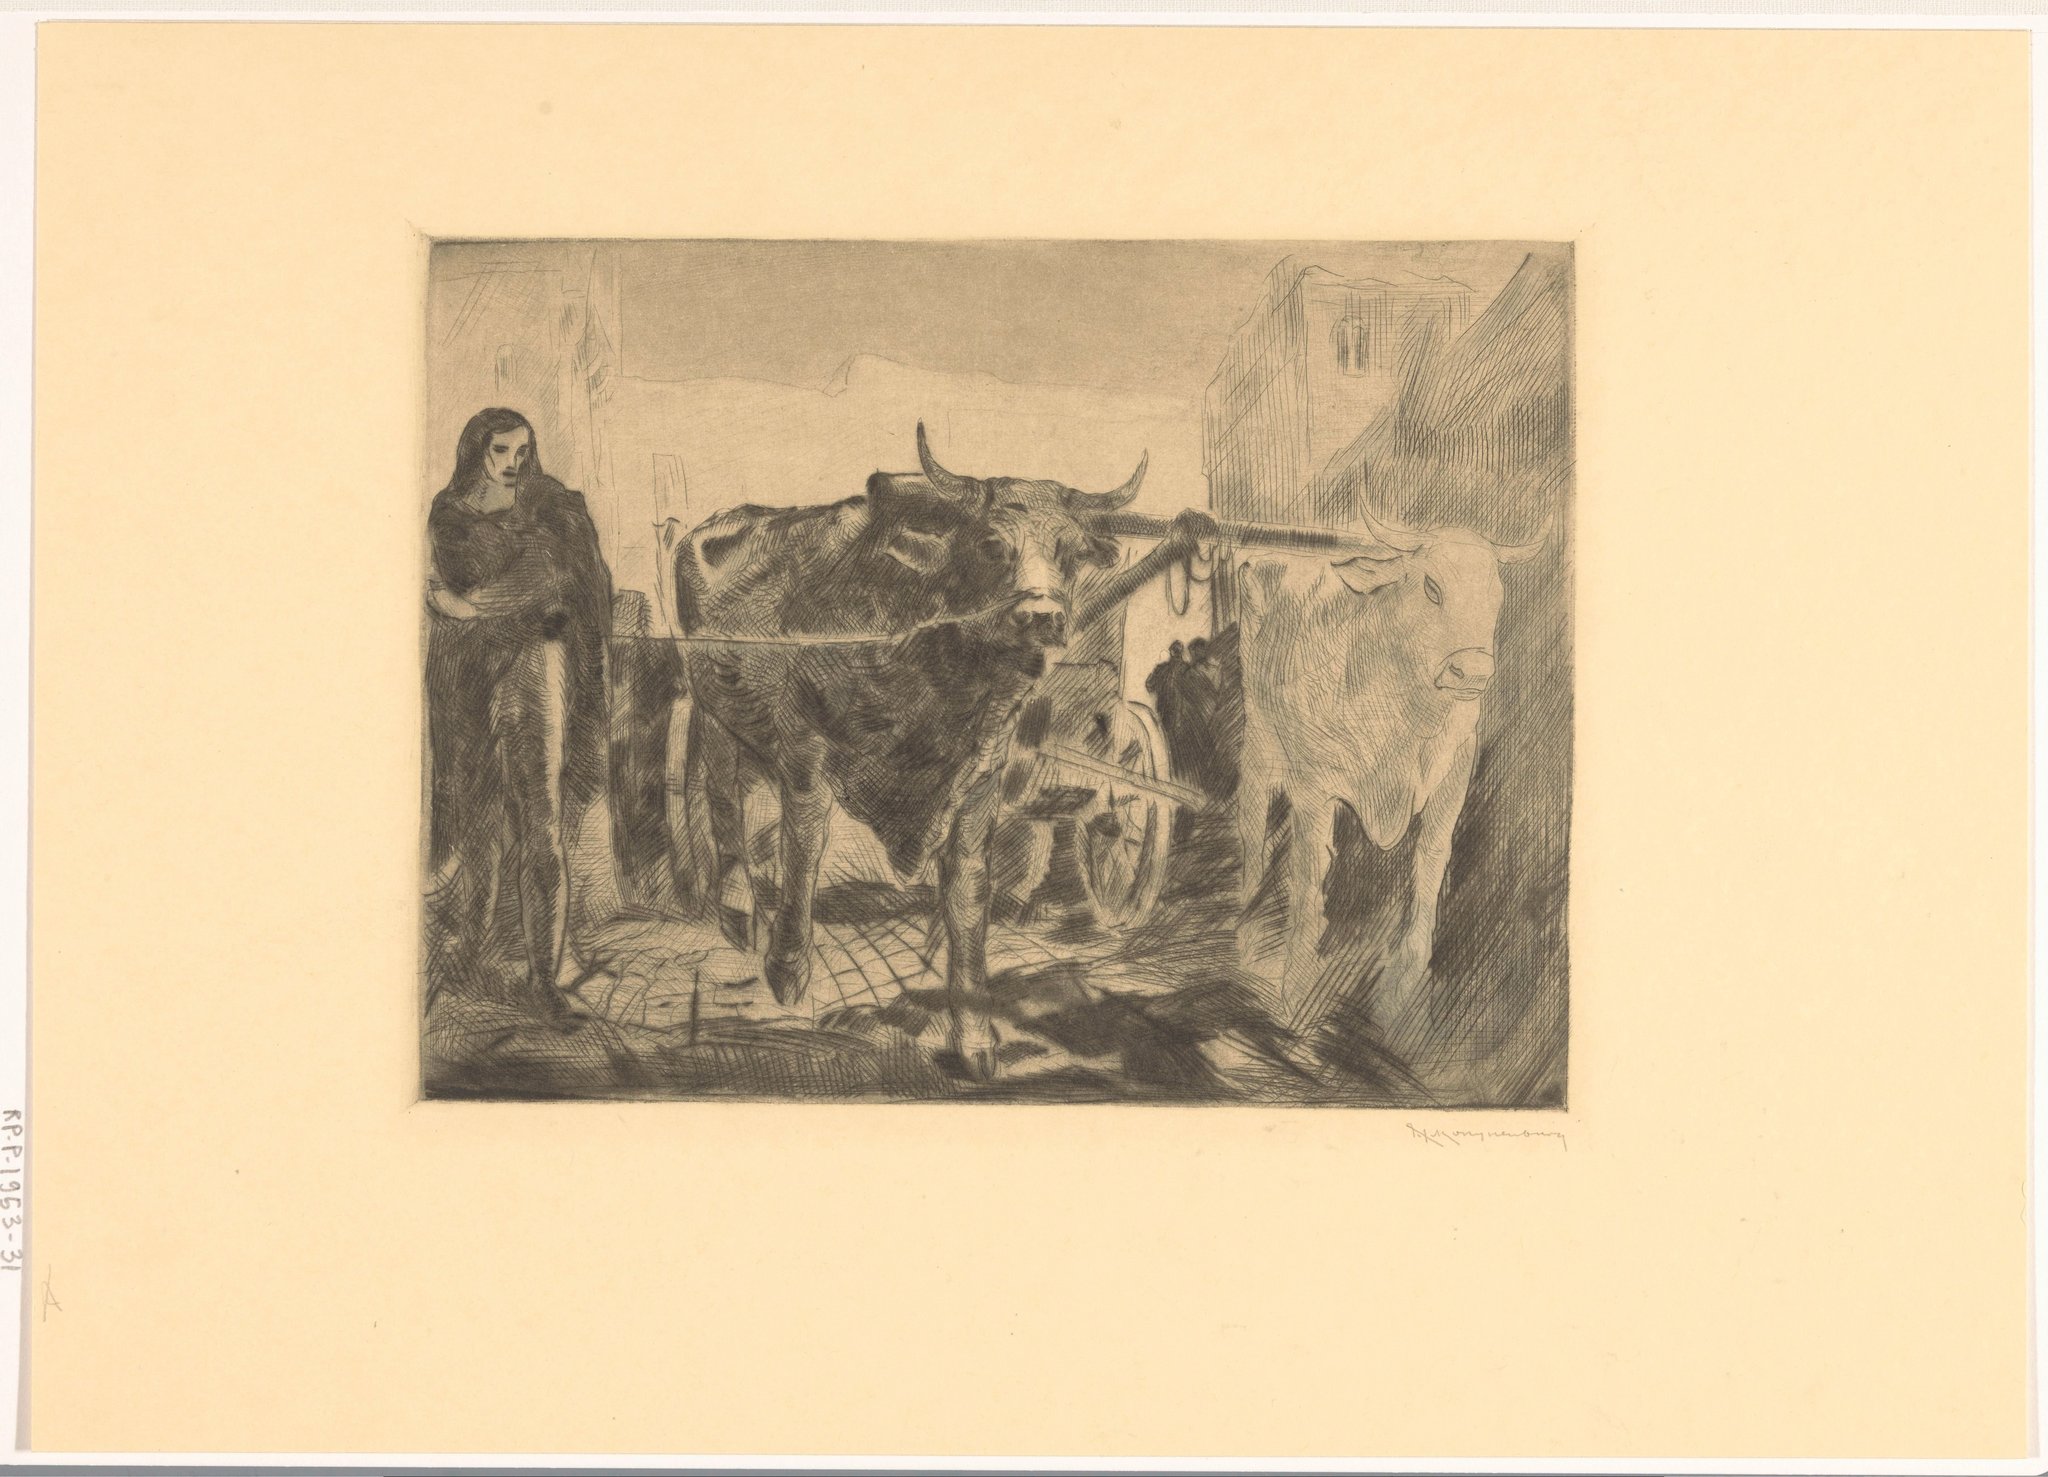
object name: print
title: Twee ossen voor een wagen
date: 1928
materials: paper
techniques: drypoint, intaglio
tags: ox, four-wheeled vehicle drawn by two animals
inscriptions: collector's mark: Lugt 2228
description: Twee ossen trekken een kar met vier wielen voort door een straat. Links een figuur die één van de ossen aan teugels vasthoudt.